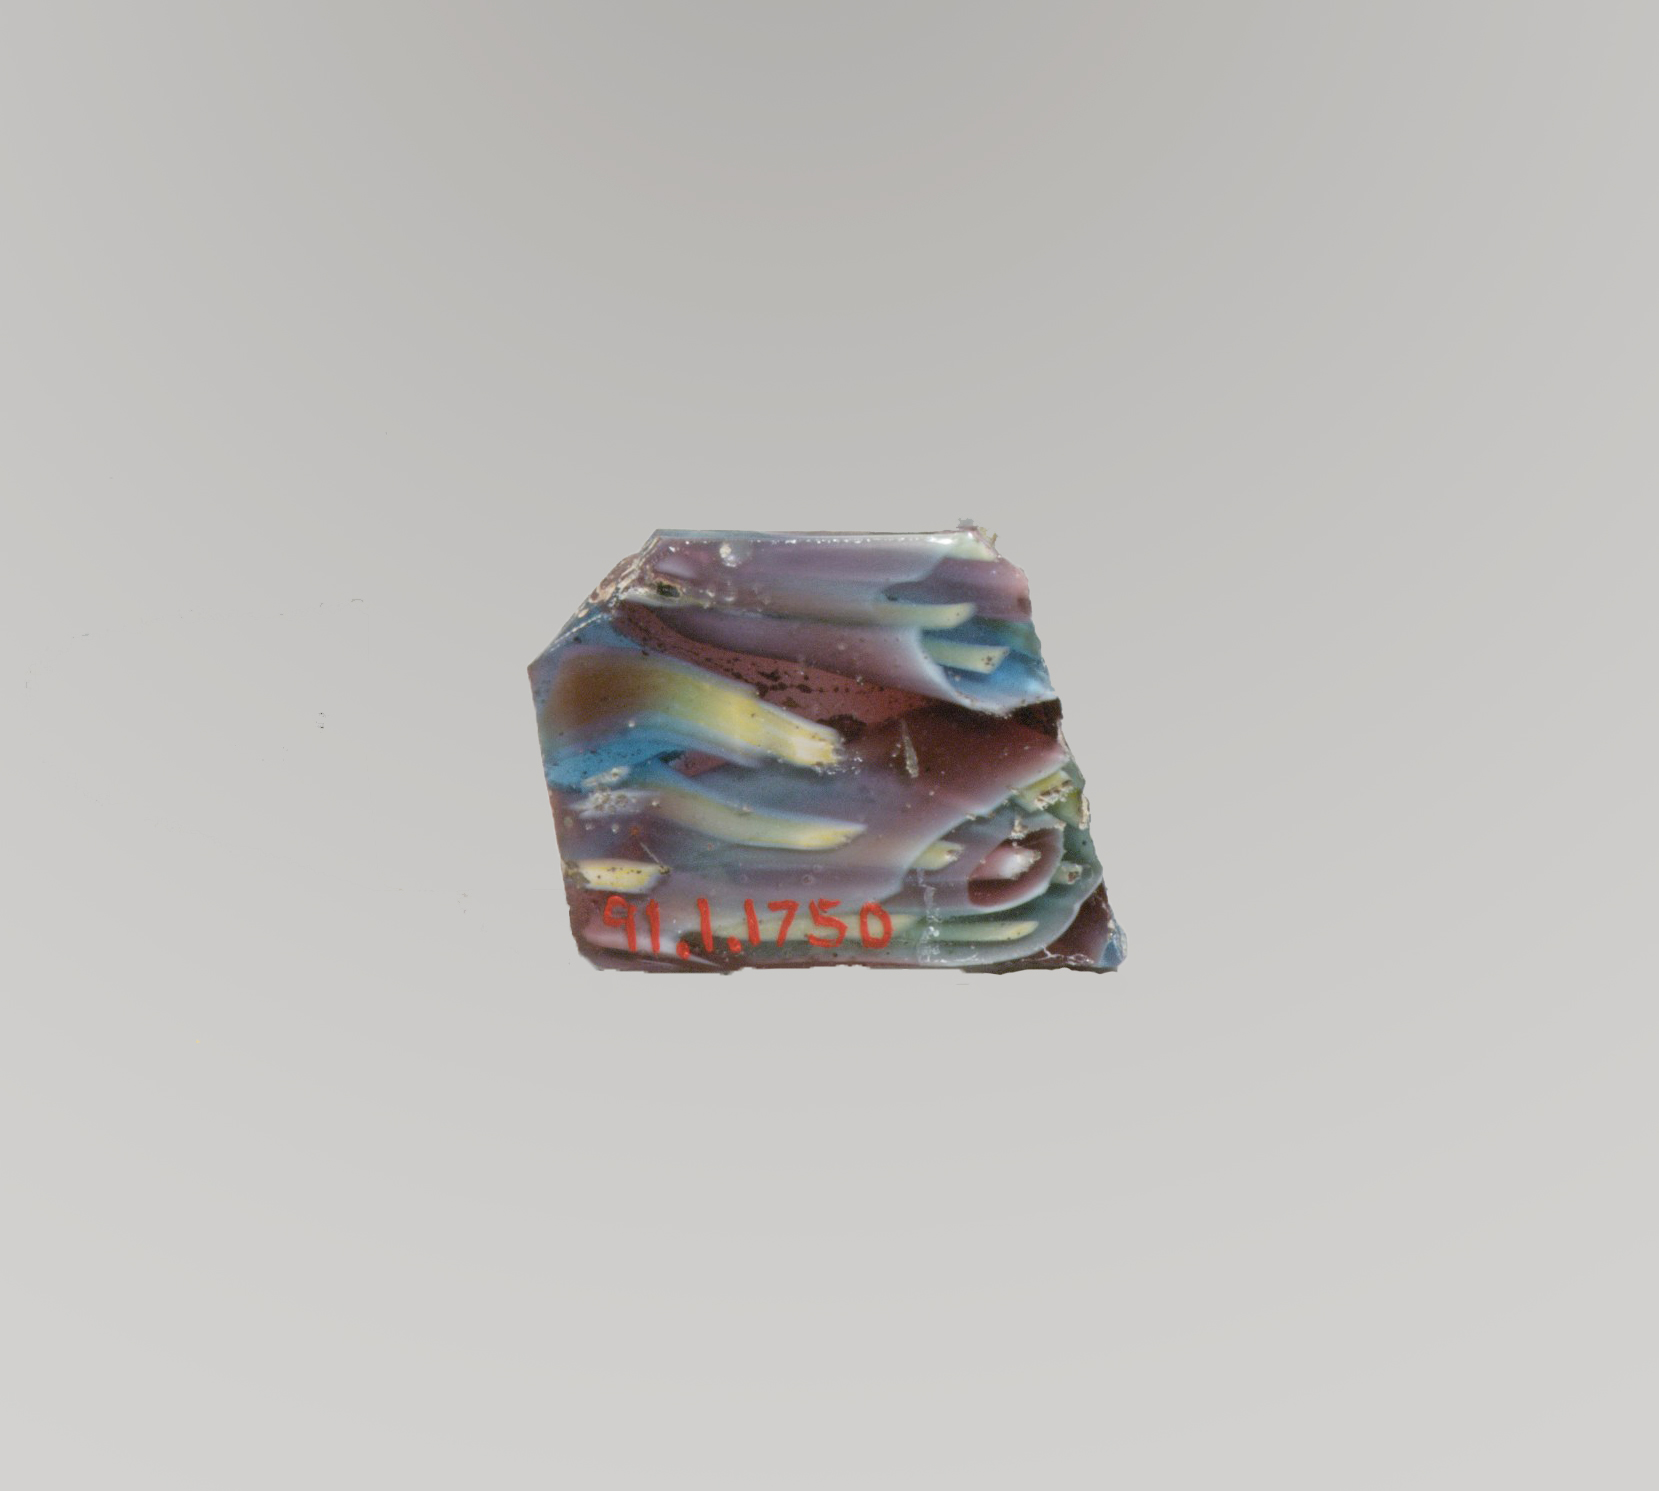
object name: fragment, mosaic bowl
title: Glass mosaic ribbed bowl fragment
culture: roman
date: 34 BCE-33 CE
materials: glass